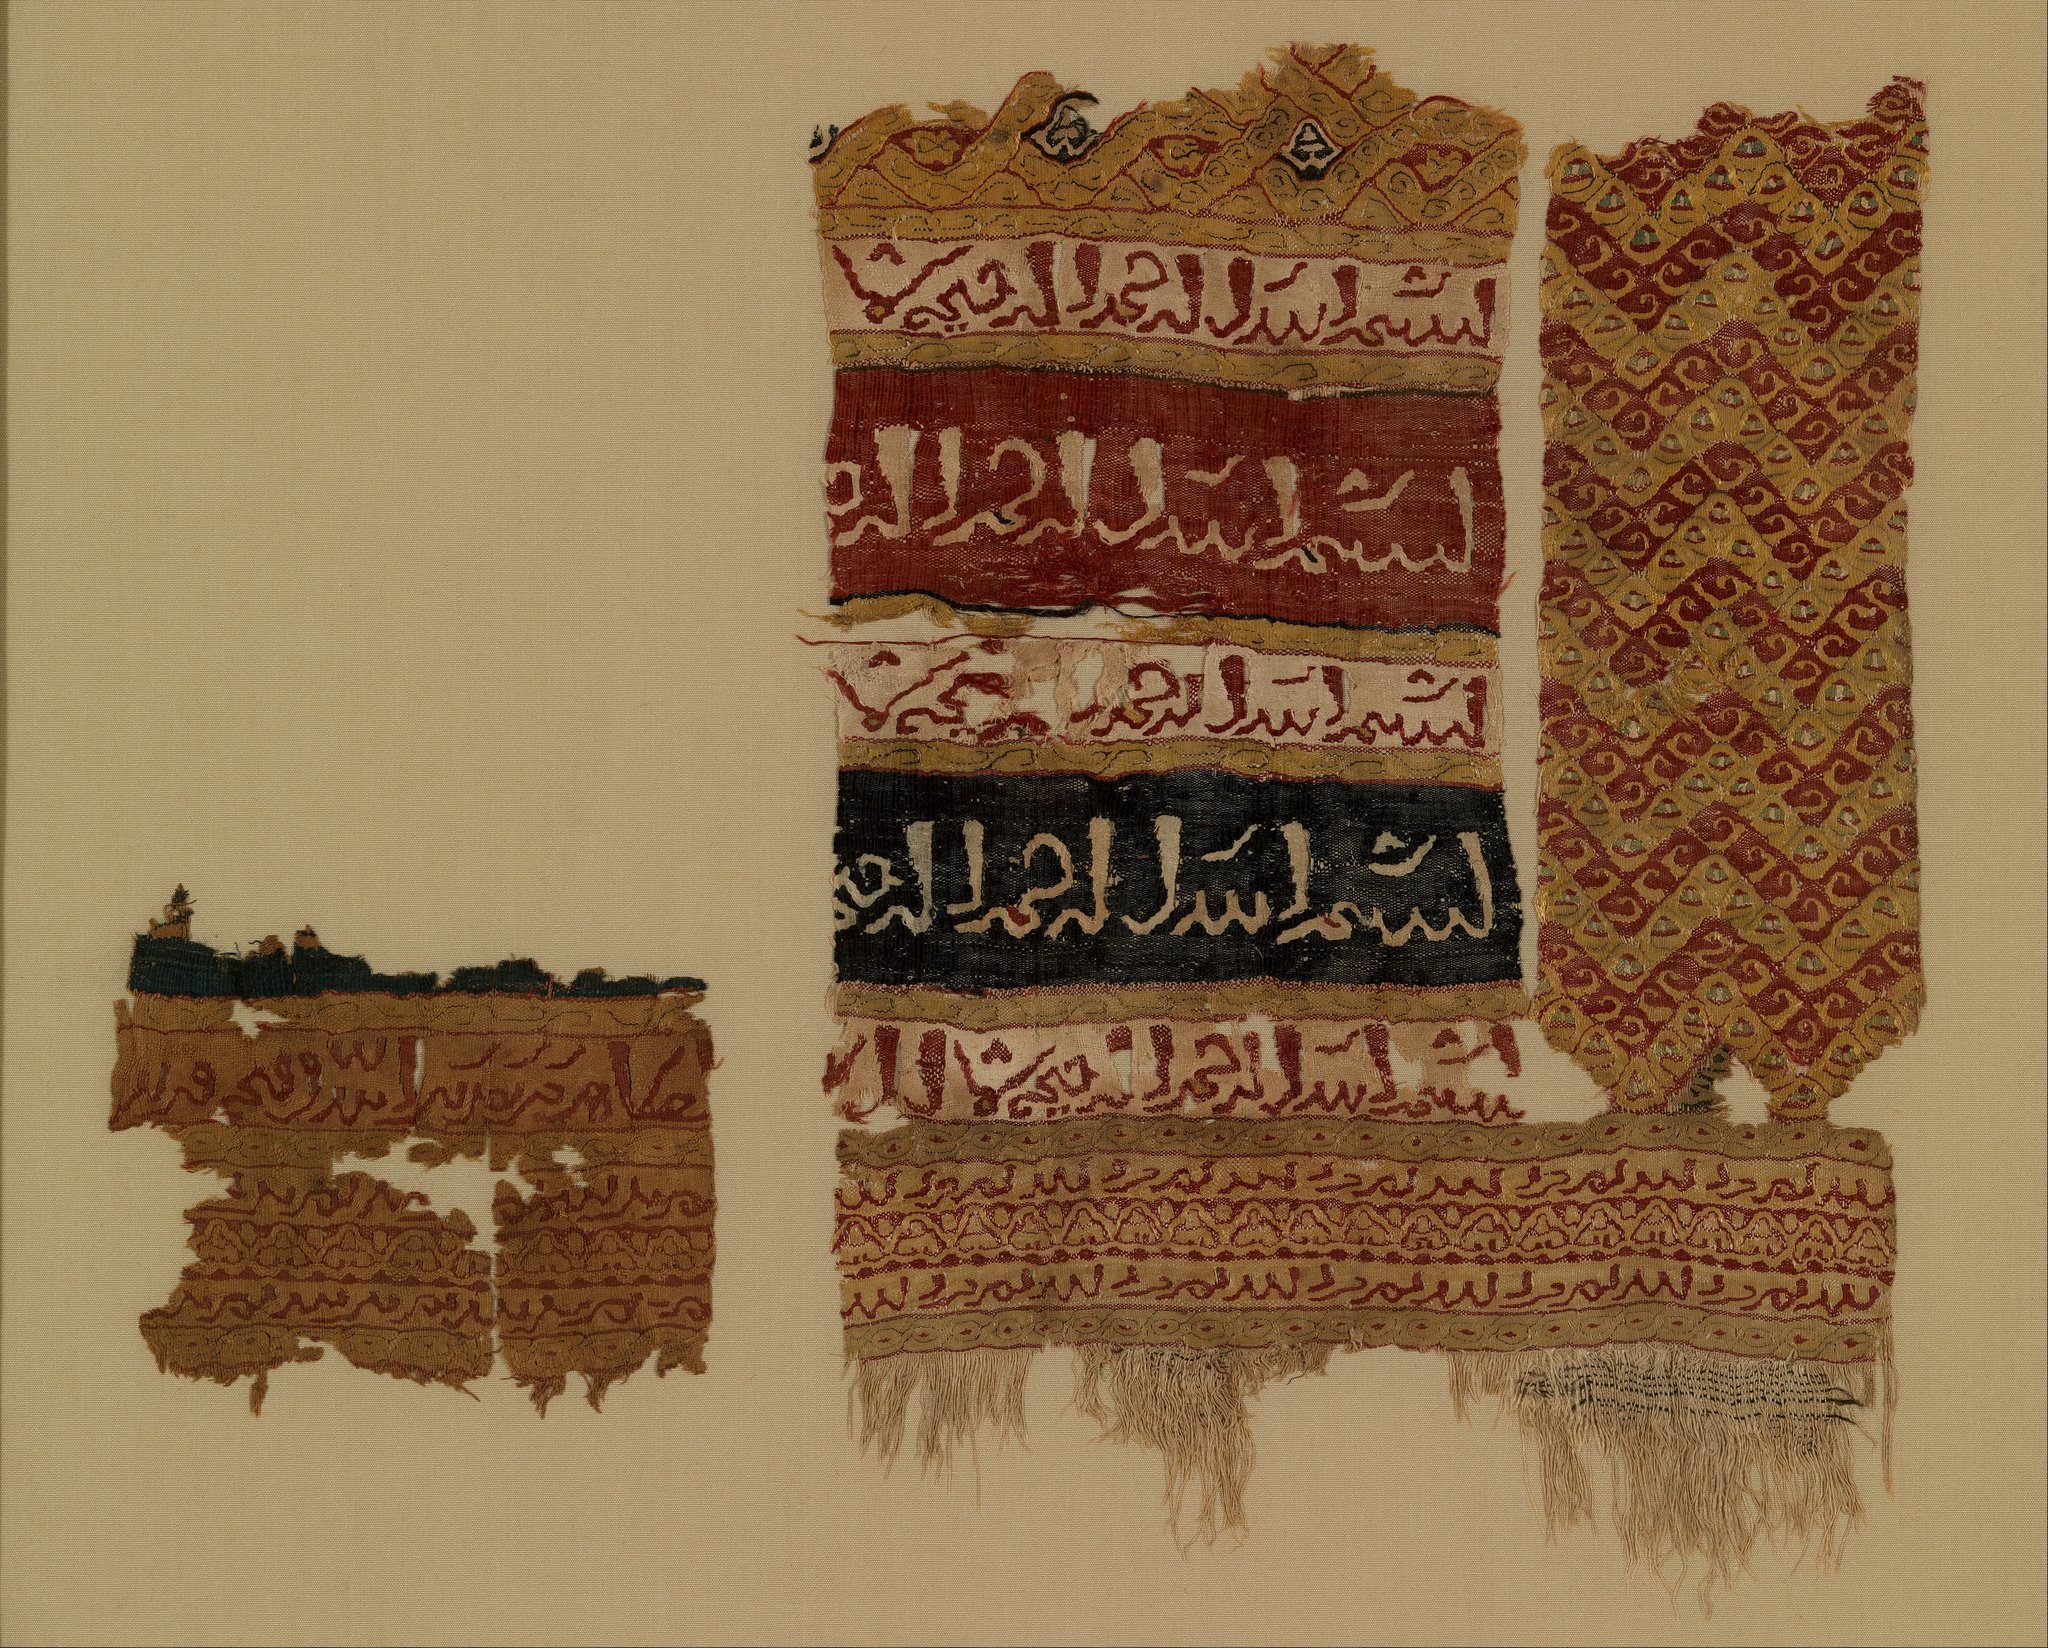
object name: textile fragment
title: Textile Featuring Arabic Inscriptions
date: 1101-1200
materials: linen, silk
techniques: weave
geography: egypt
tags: arabic